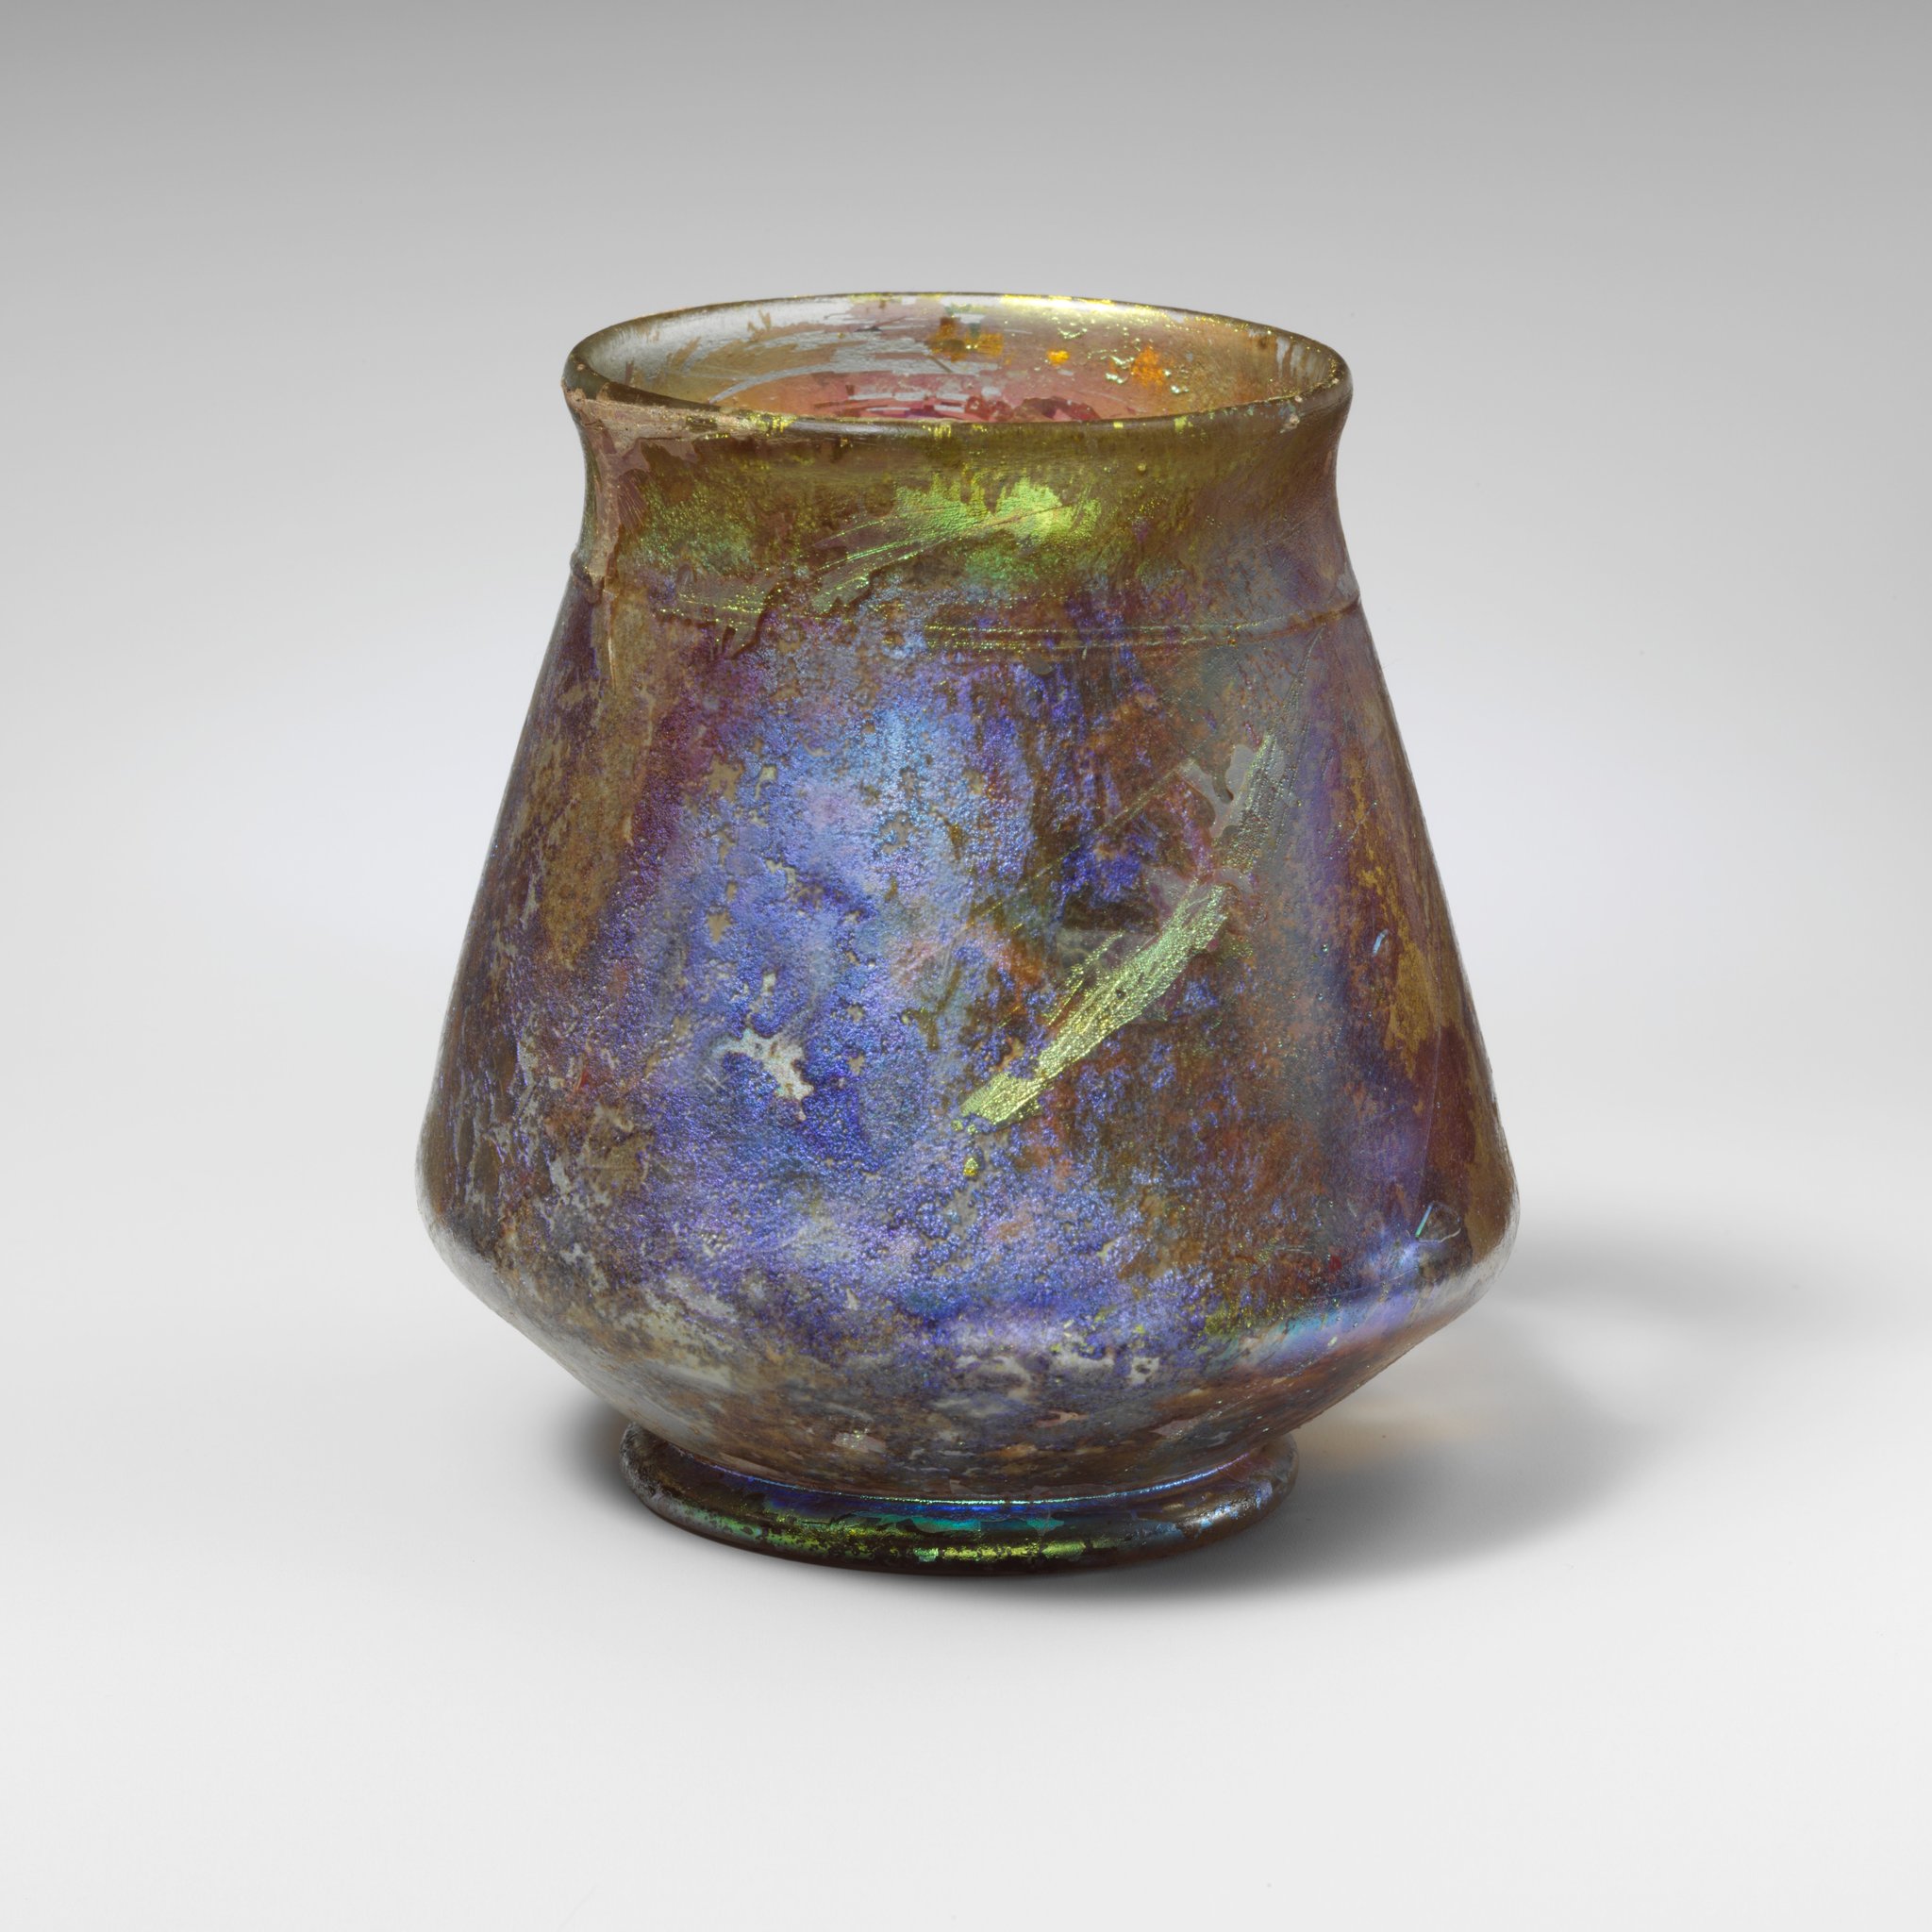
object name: cup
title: Glass cup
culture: roman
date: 101-300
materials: glass